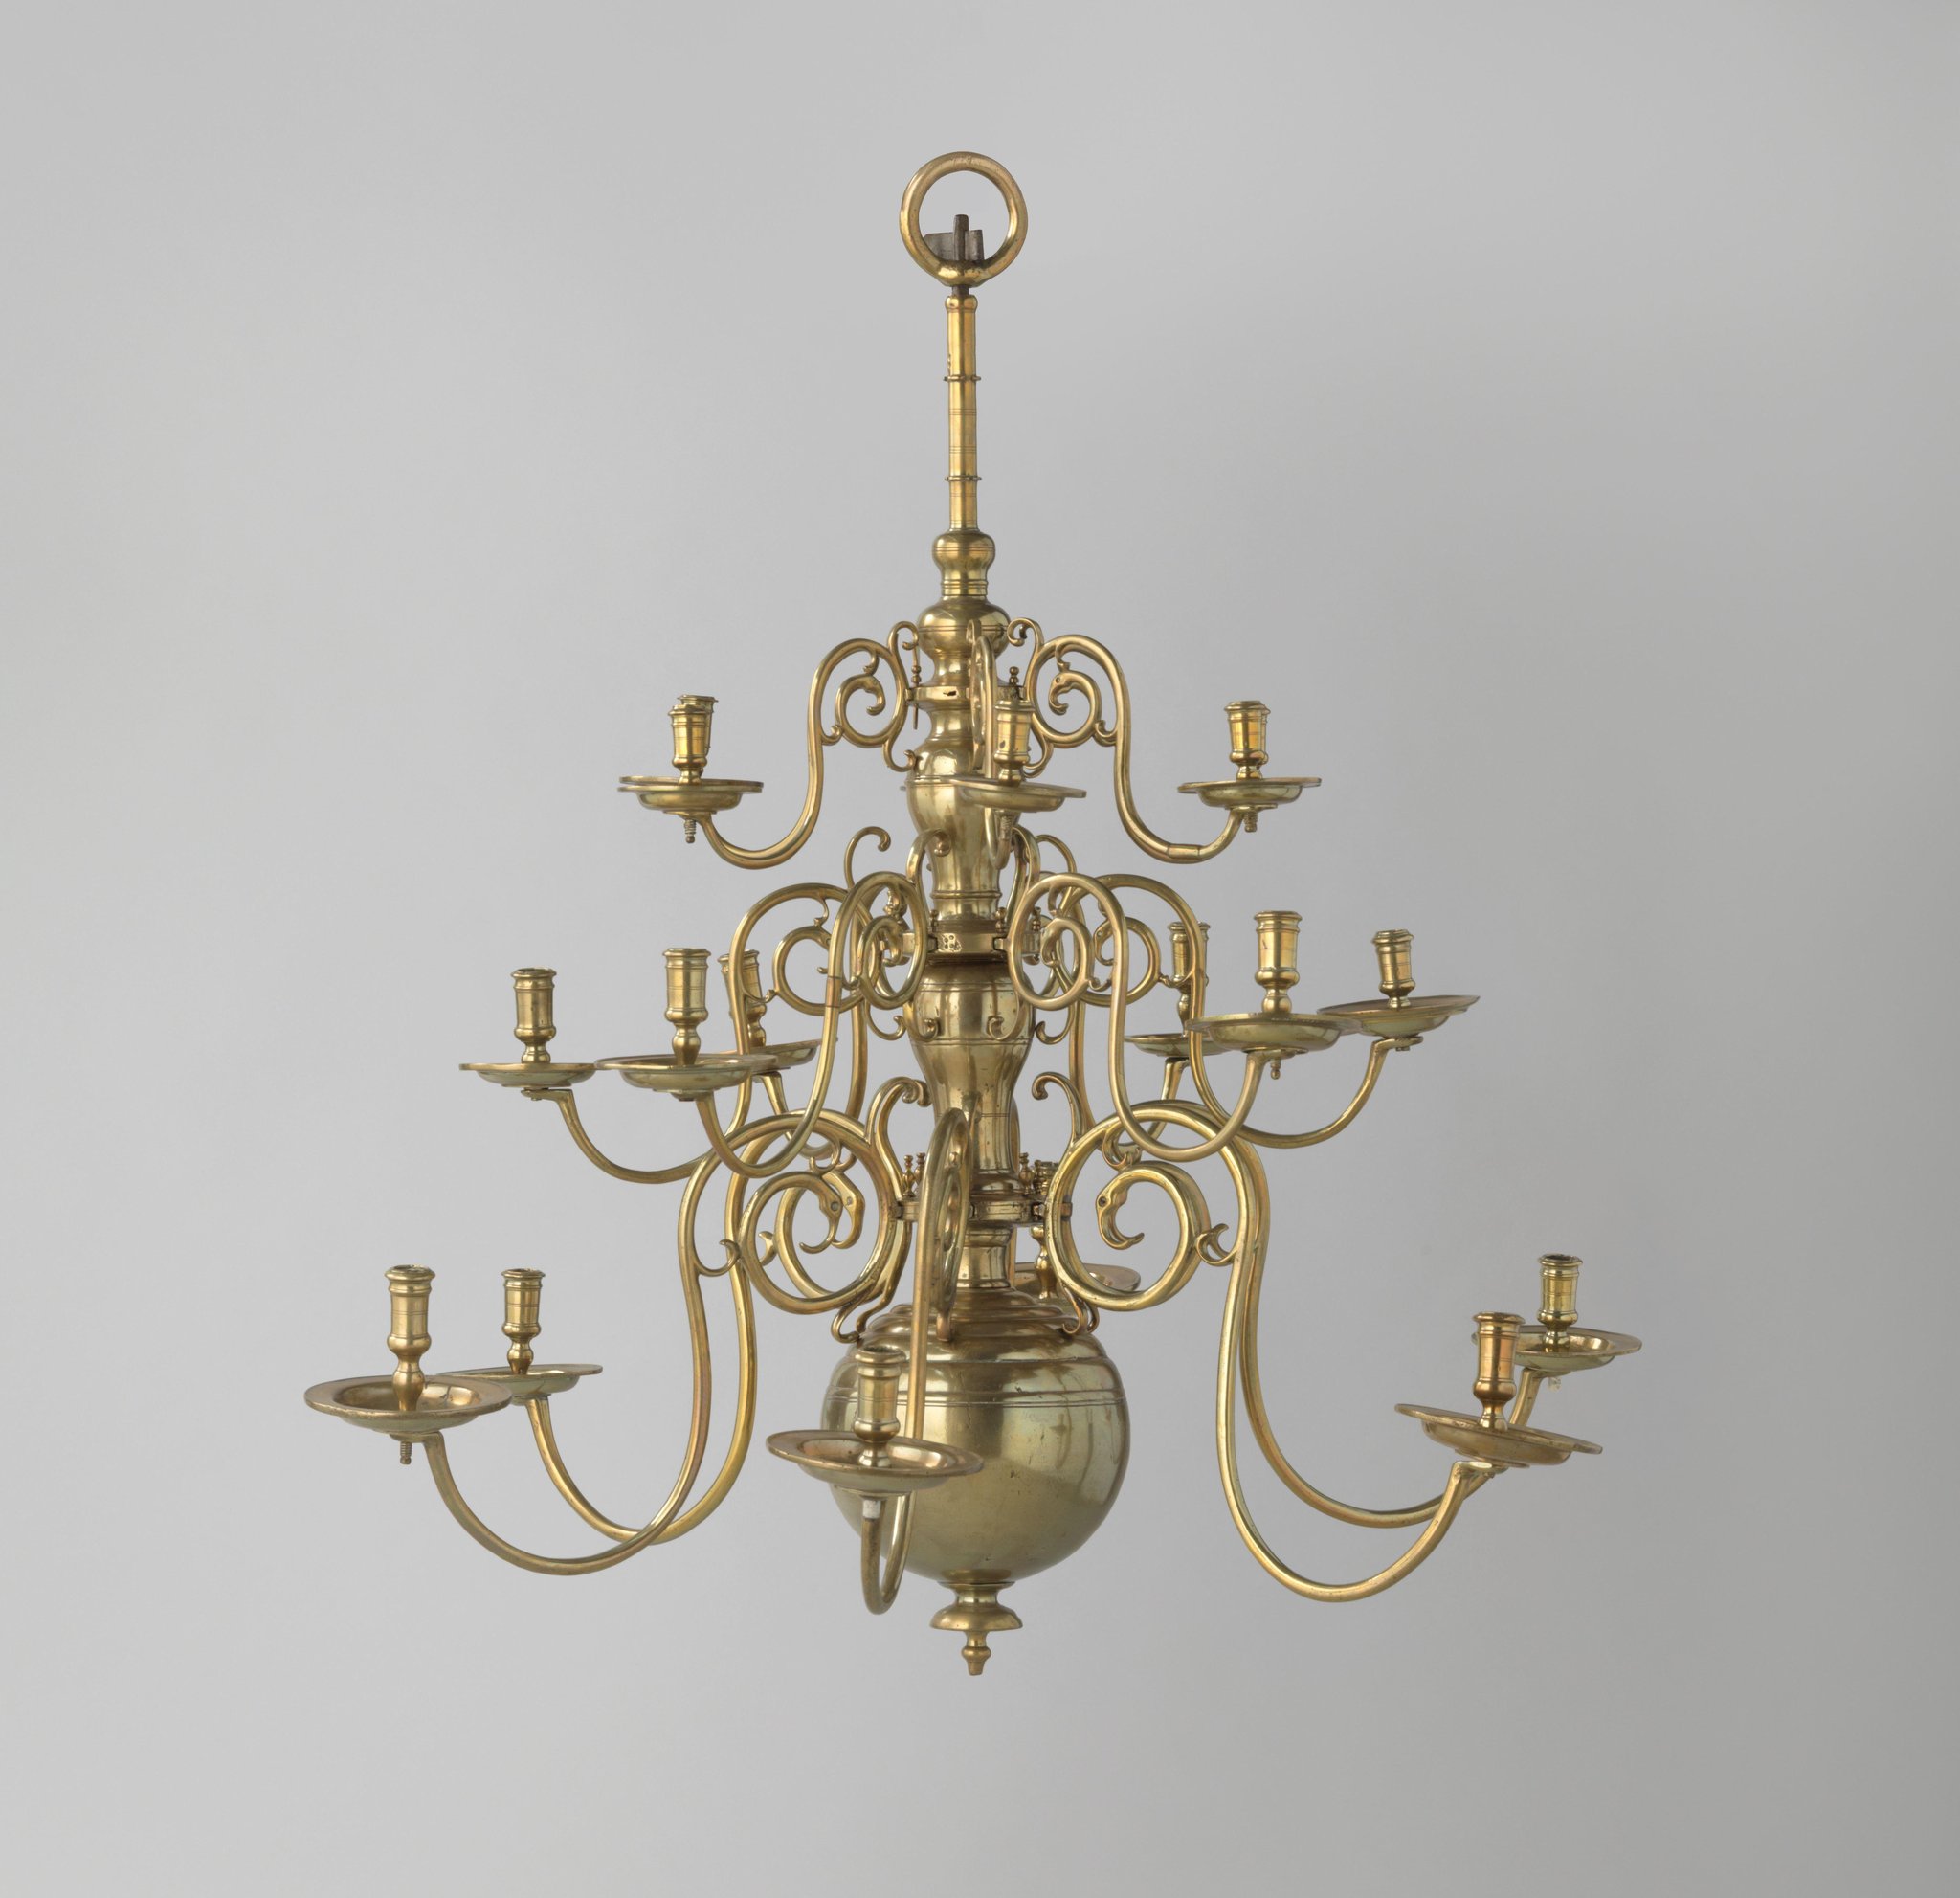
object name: chandelier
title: Arm met kaarsenhouder van kaarsenkroon van drie hoogten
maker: Anonymous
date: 1675-1725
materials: brass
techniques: casting, screwed, turning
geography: southern netherlands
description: Kaarsenarm behorende bij een messing kaarsenkroon van drie hoogten. De S-vormige arm heeft een krul en gaat naar buiten toe over in het platte verdikking met een schroefgat. Daarin is de kaarsenhouder met de vetvanger vastgezet. De vetvanger is aan de onderzijde geribd geprofileerd rond de opening en heeft verder twee gegroefde ringen en een enkele gegroefde ring. De cylindrische kaarsenhouder, die een geprofileerde uitstekende rand, twee gegroefde ringen en een verdikking onderaan heeft, gaat over in een baluster met onderaan het eind met schroefdraad met een vlakke onderzijde. Dit is de vierde arm van de middelste standring, genummerd met 4 ronde punten. De pin, om de arm aan de standring te bevestigen, heeft bovenop een ronde knop.